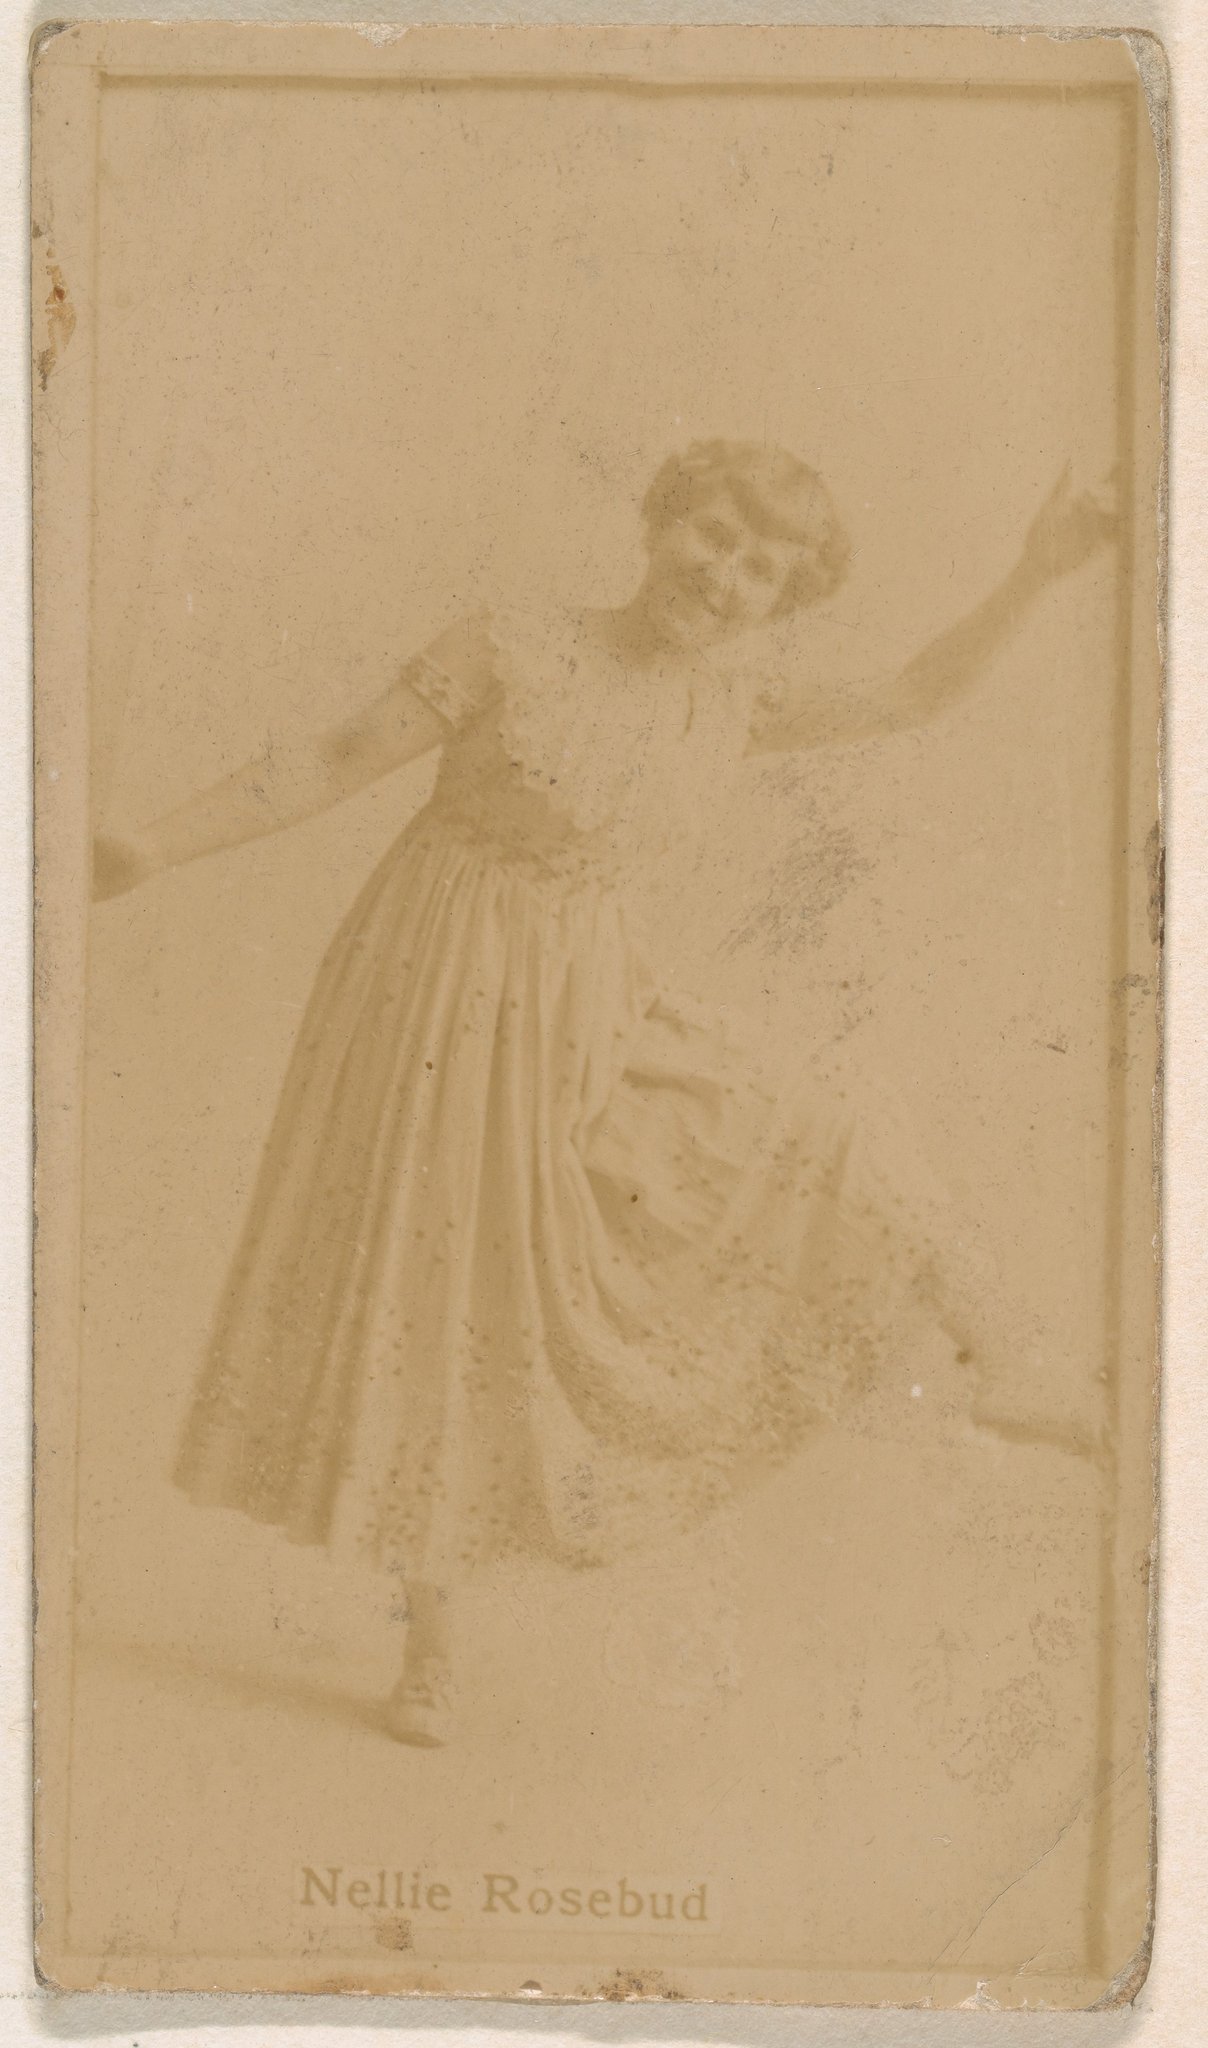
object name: photograph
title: Nellie Rosebud, from the Actresses series (N245) issued by Kinney Brothers to promote Sweet Caporal Cigarettes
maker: kinney brothers tobacco company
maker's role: publisher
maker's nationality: american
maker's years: 1869-2011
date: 1890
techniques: albumen silver print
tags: portraits,women,actresses